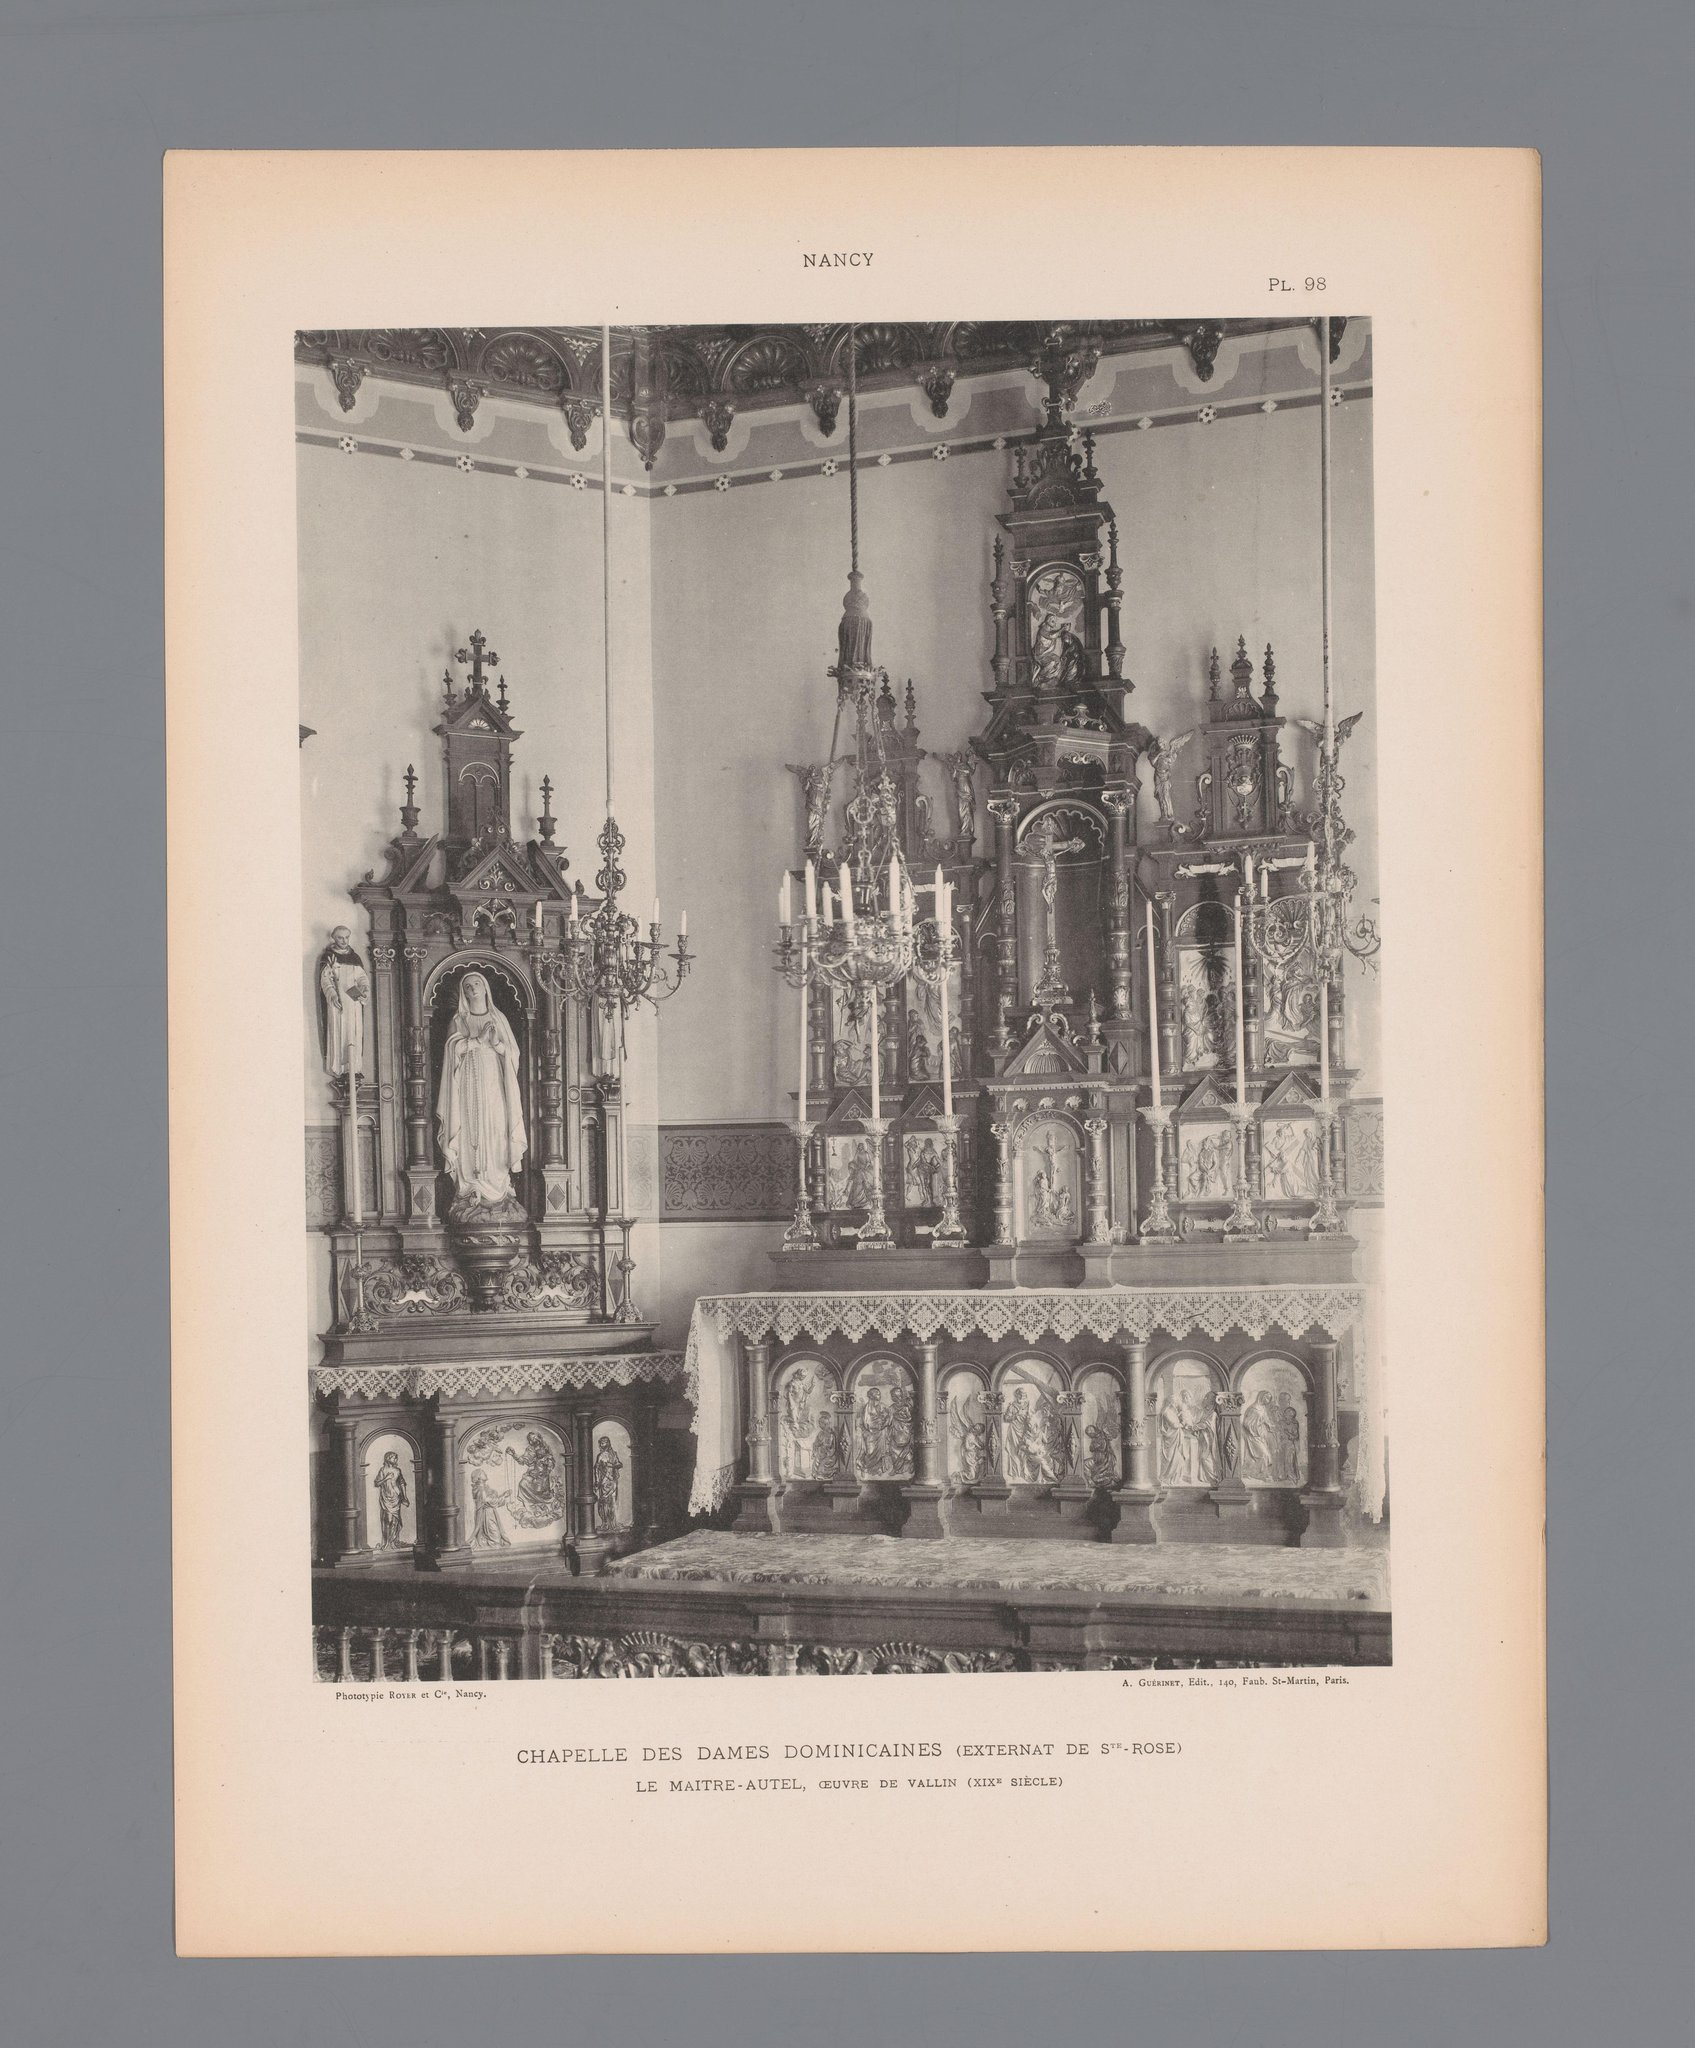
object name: photomechanical print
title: Altaar in de Couvent des Dominicains te Nancy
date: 1891-1896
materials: paper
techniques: photograph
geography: paris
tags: cloisters ~ monastery, altar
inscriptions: inscription: ‘Chapelle des dames Dominicaines (externat de Ste-Rose)/ Le maitre-autel, (oeuvre de Vallin (XIXe siècle)’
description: Deze prent maakt deel uit van een omslag met 103 prenten op 101 bladen en een titelblad.